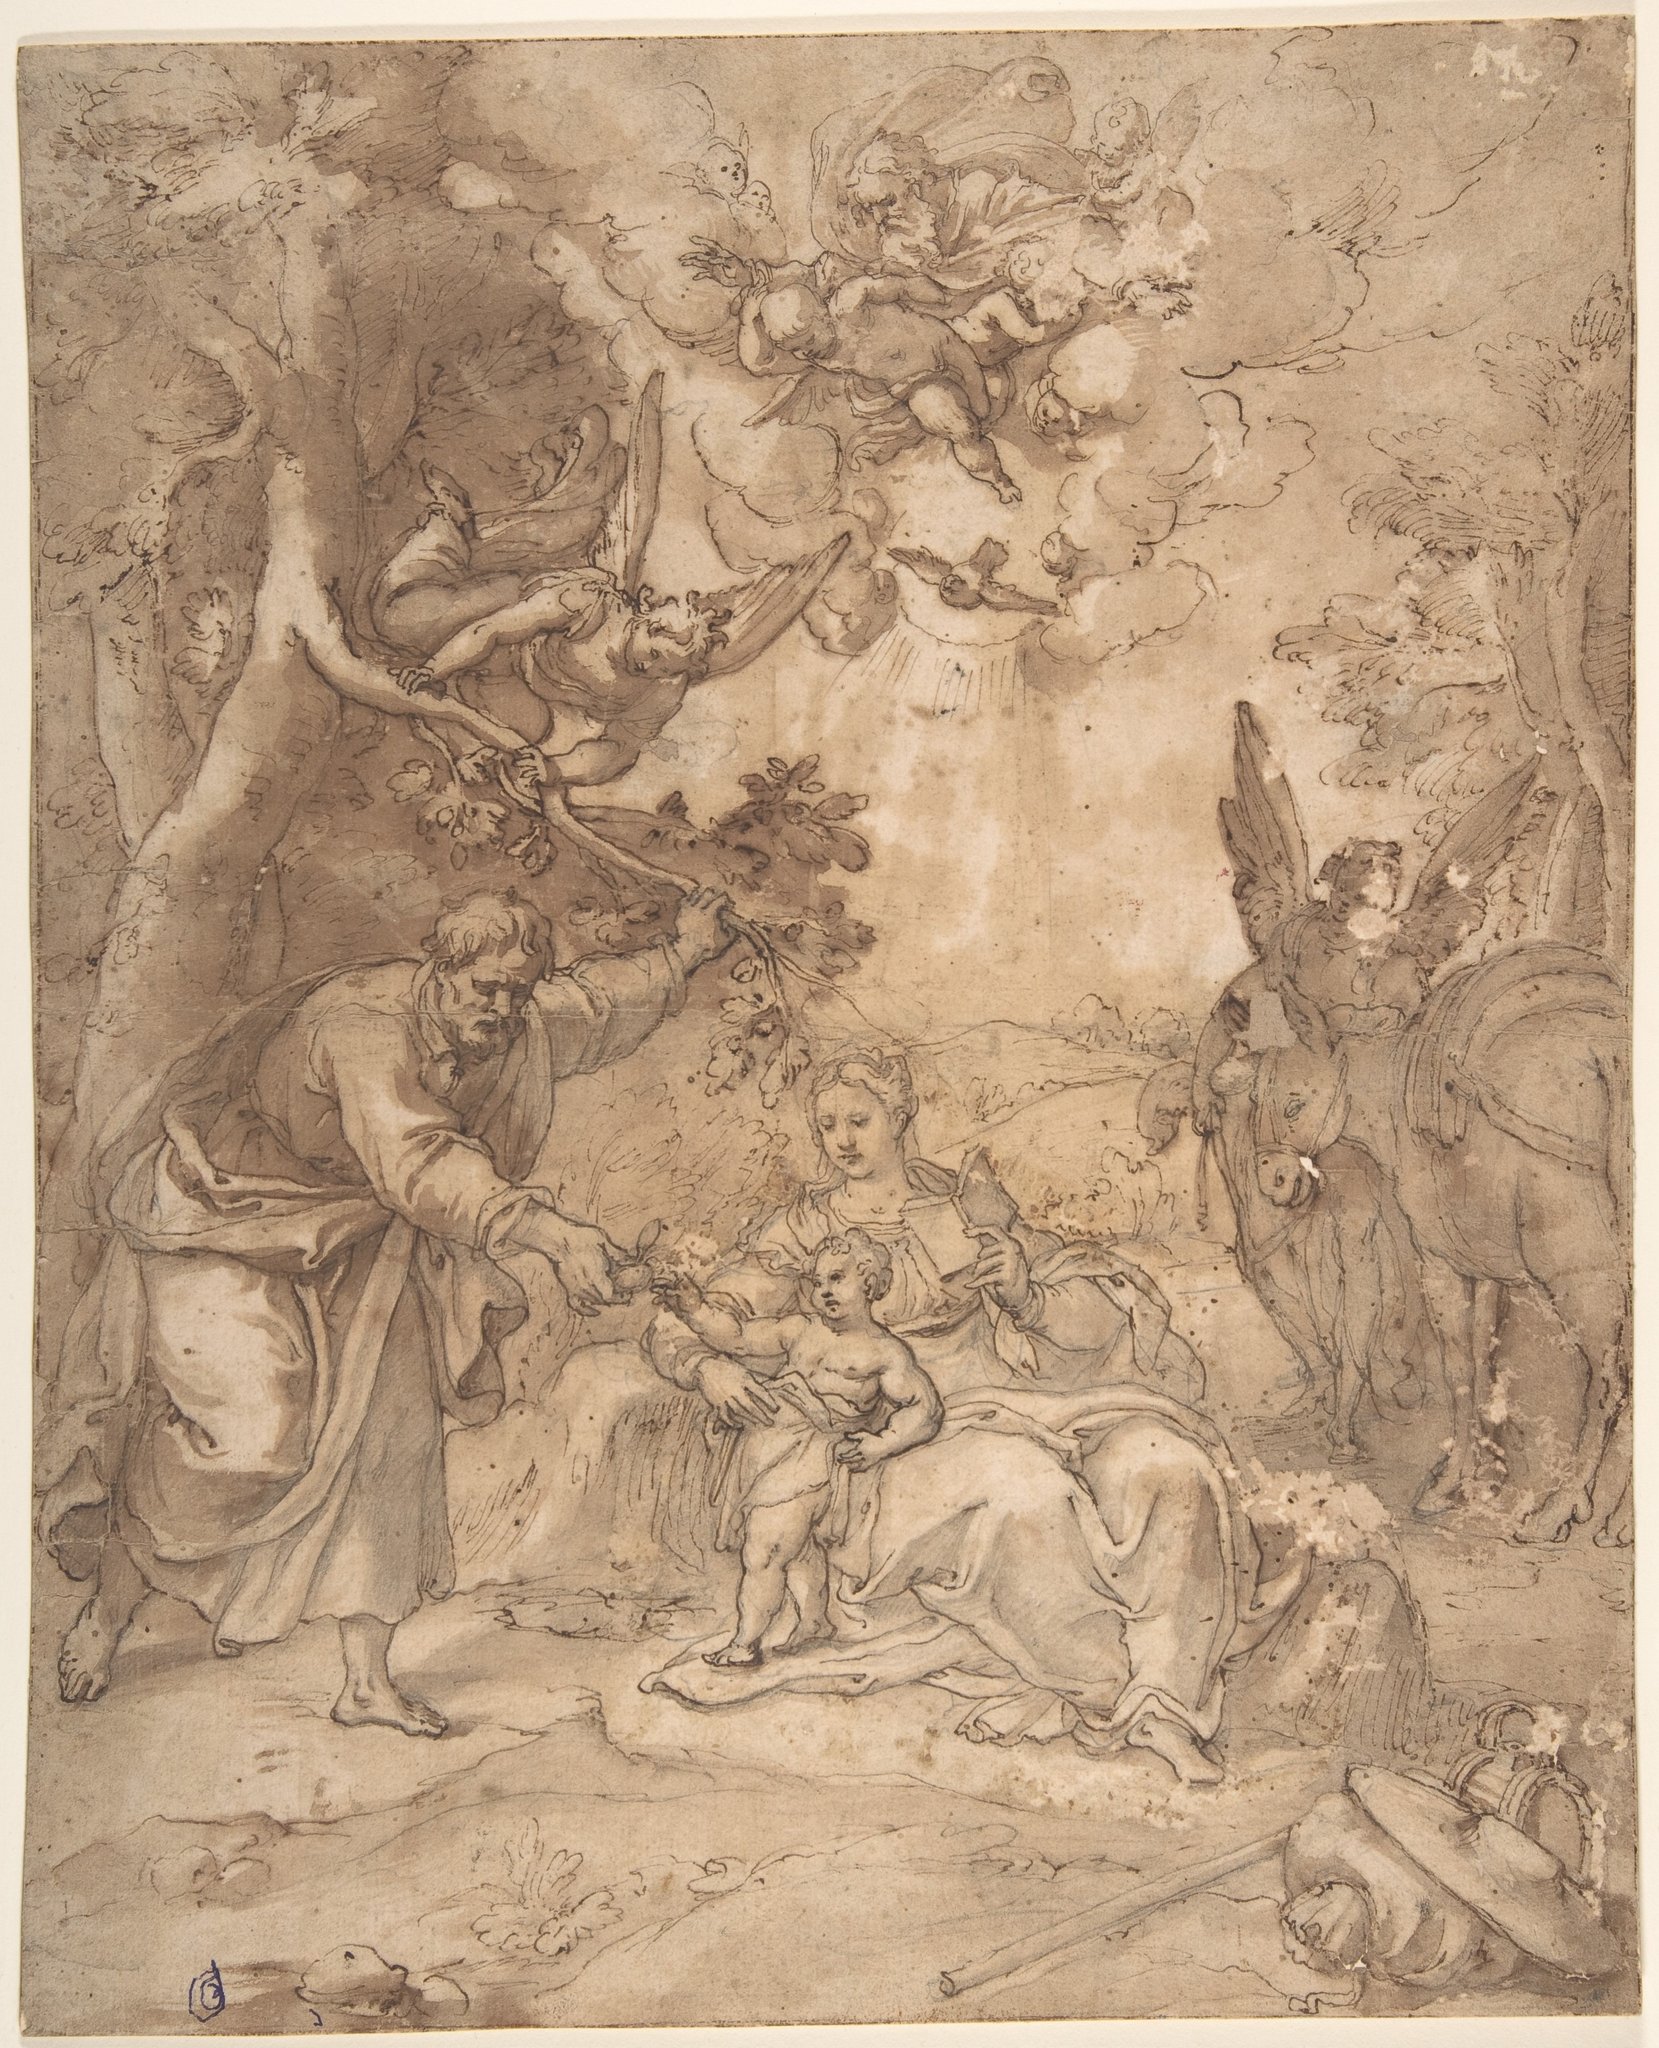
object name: drawing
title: Rest on the Flight to Egypt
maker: anonymous, netherlandish, 16th century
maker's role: artist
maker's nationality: netherlandish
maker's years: 1500-1600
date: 1501-1600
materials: chalk, ink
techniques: brush, pen, wash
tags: donkeys,angels,christ,holy family,saint joseph,virgin mary